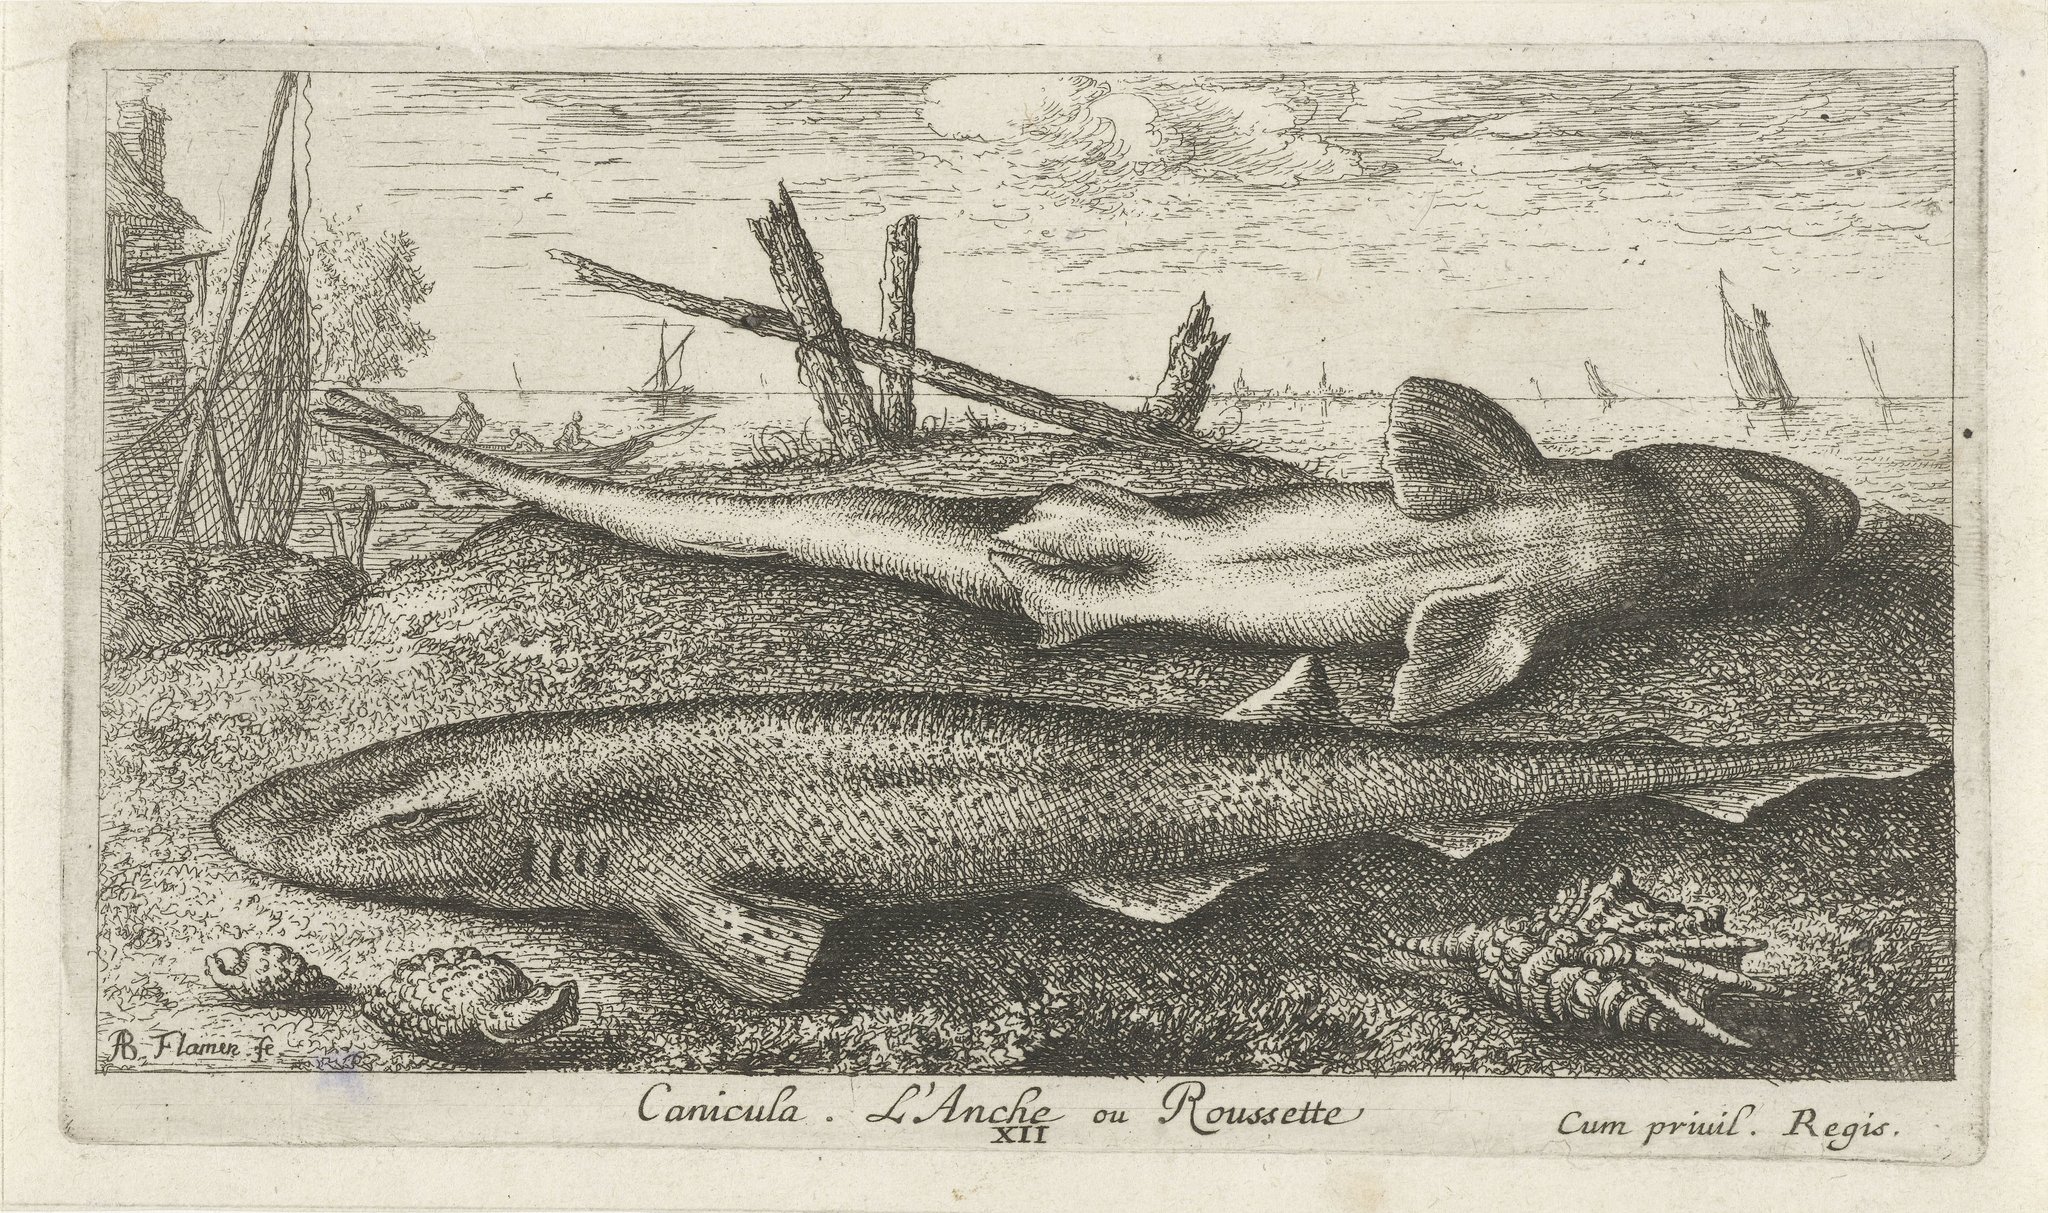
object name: print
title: Vissen en andere zeedieren - zoutwater tweede reeks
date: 1664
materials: paper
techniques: etching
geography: paris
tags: cartilaginous fishes: dogfish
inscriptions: collector's mark: Lugt 2228, collector's mark: Lugt 1490